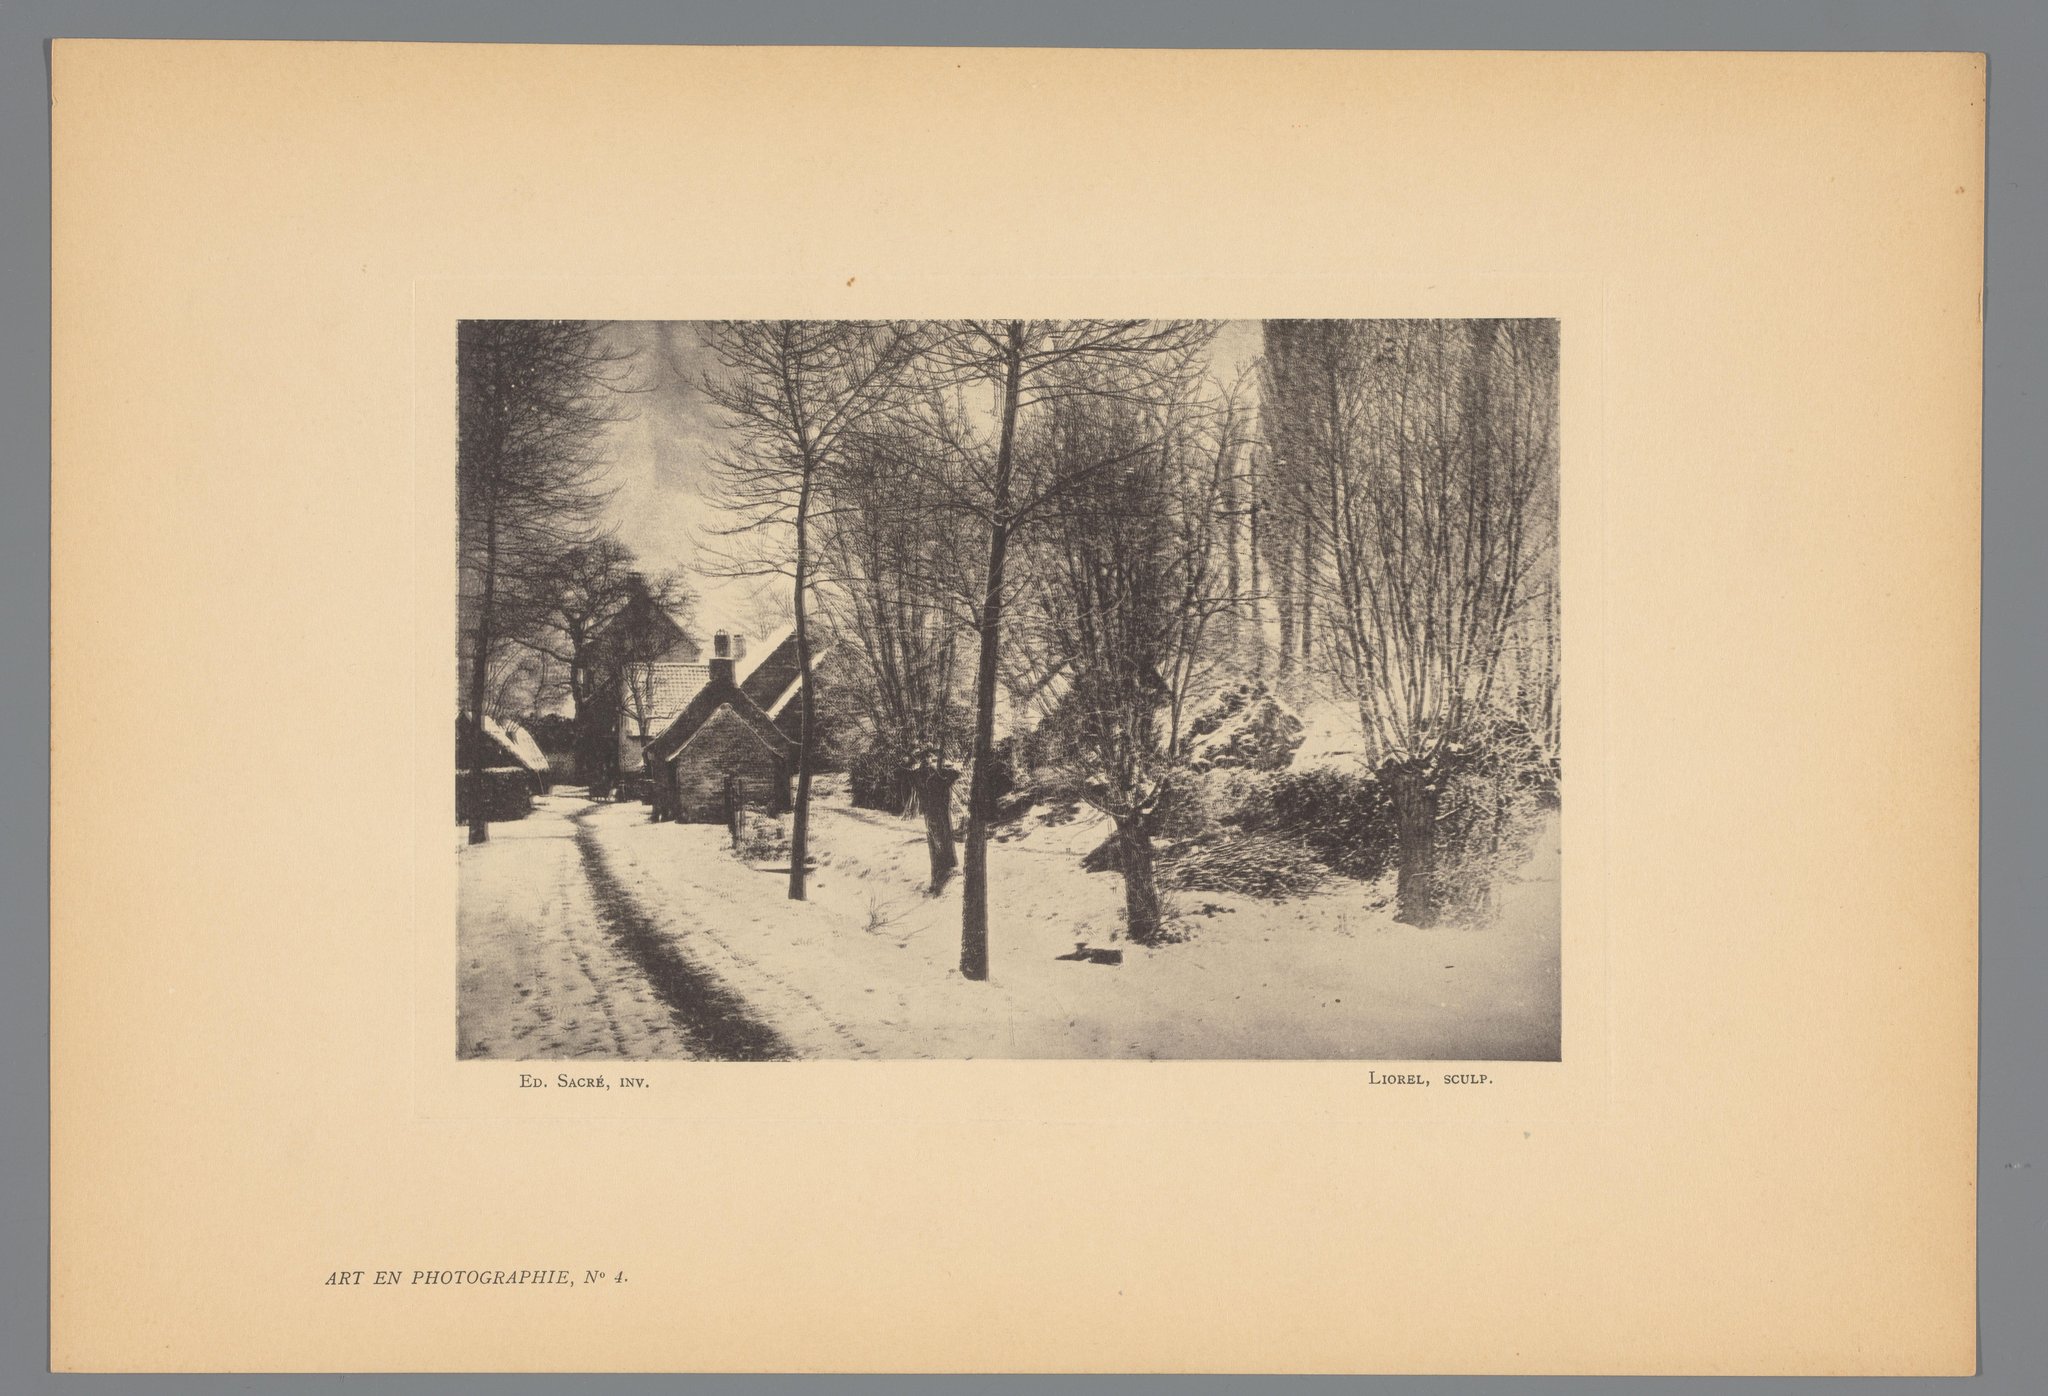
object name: photomechanical print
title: Winterlandschap met enkele huizen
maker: edmond sacré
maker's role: fotograaf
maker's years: 1851-1921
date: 1896-1901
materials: paper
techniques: photograph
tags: winter landscape; landscape symbolizing winter (the four seasons of the year), civic architecture; edifices; dwellings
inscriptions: inscription: ‘ART EN PHOTOGRAPHIE, No 4.’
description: Deze prent maakt deel uit van een omslag met 54 prenten op 52 bladen.